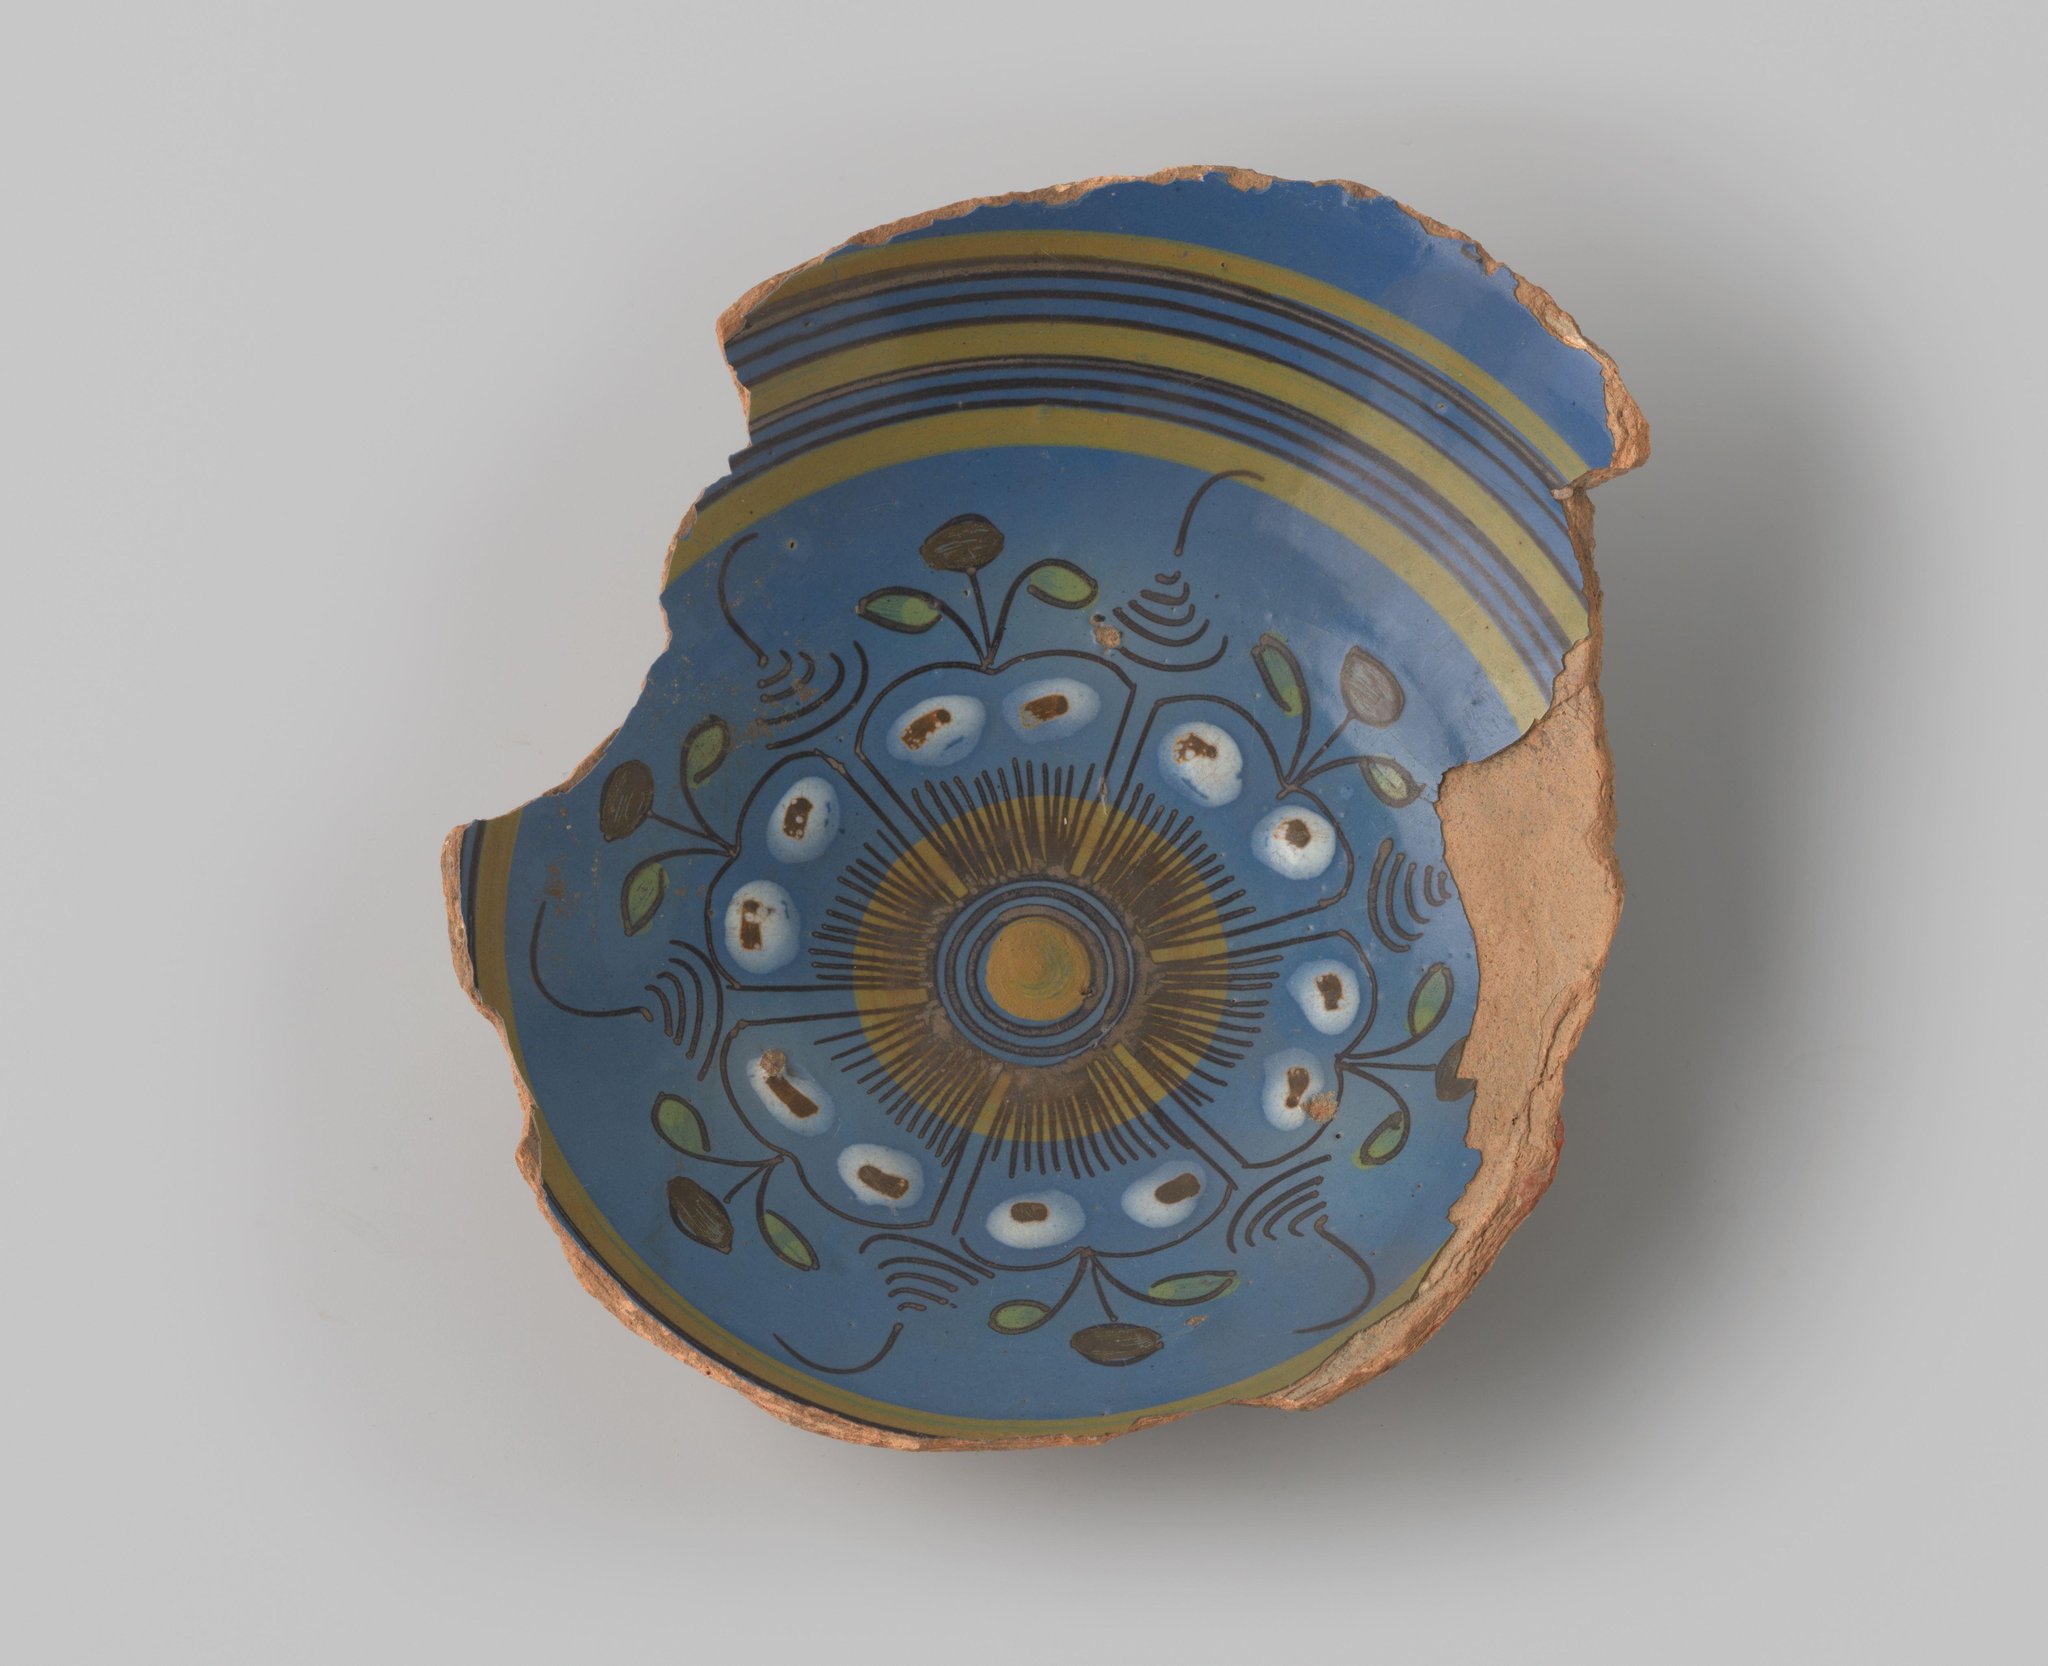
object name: sherd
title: Scherf van geligbakkend aardewerk, met voetring, aan de voorzijde voorzien van blauw glazuur, met op het plat een schildering met bladeren en bloemen in bruin, blauw, groen, oranje, geel en wit, en daar omheen cirkels in bruin en geel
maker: Anonymous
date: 1600-1650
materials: earthenware, glaze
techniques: maiolica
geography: northern netherlands